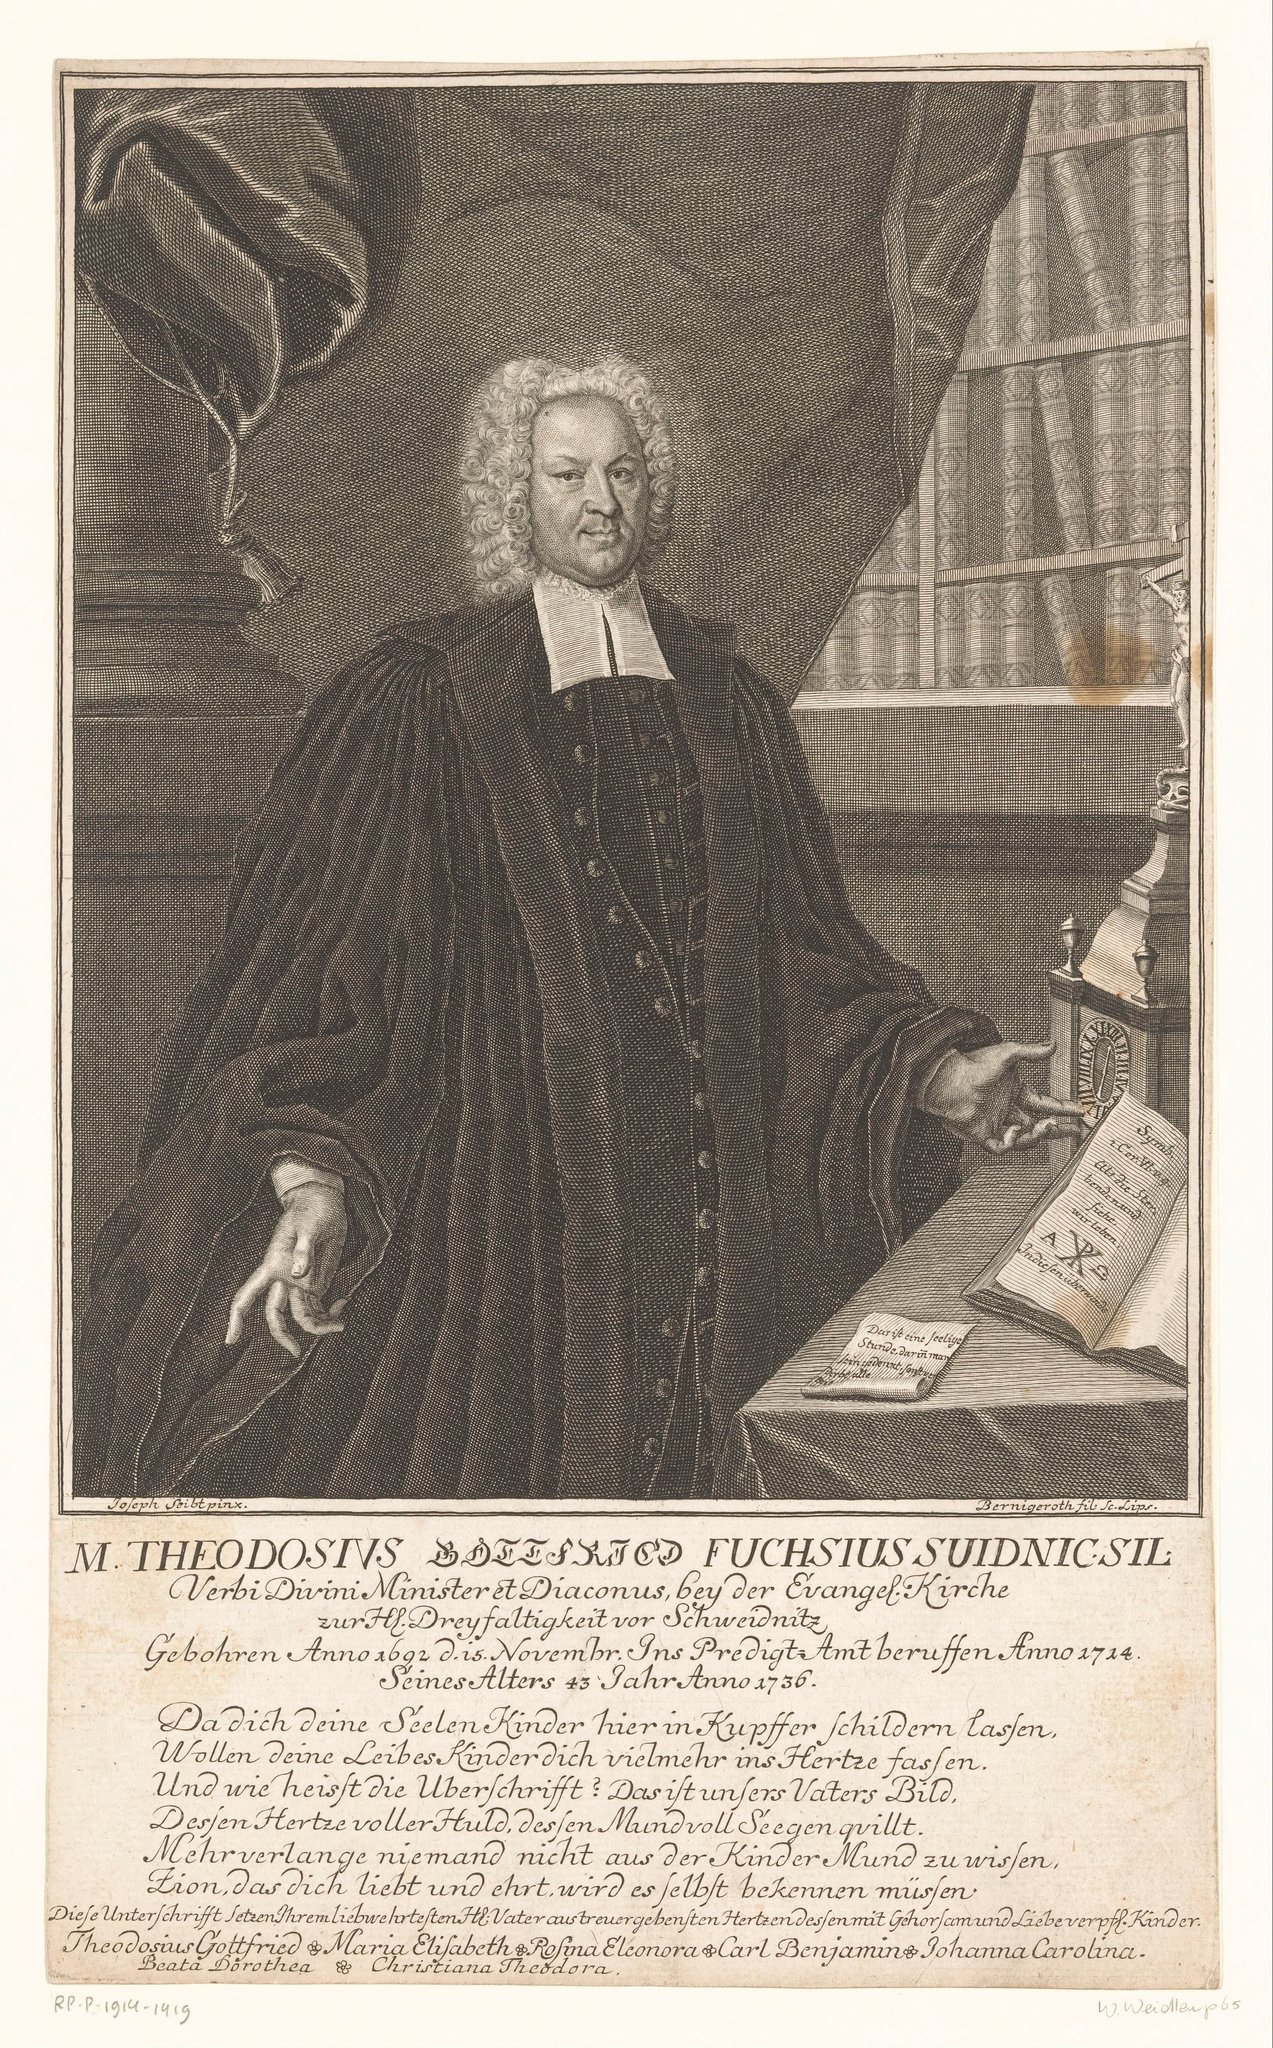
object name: print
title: Portret van Theodosius Gottfried Fuchs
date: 1736-1767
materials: paper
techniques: engraving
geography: leipzig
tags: bookshelves, historical persons, book, clock, crucifix ~ personal devotion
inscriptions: collector's mark: Lugt 2228